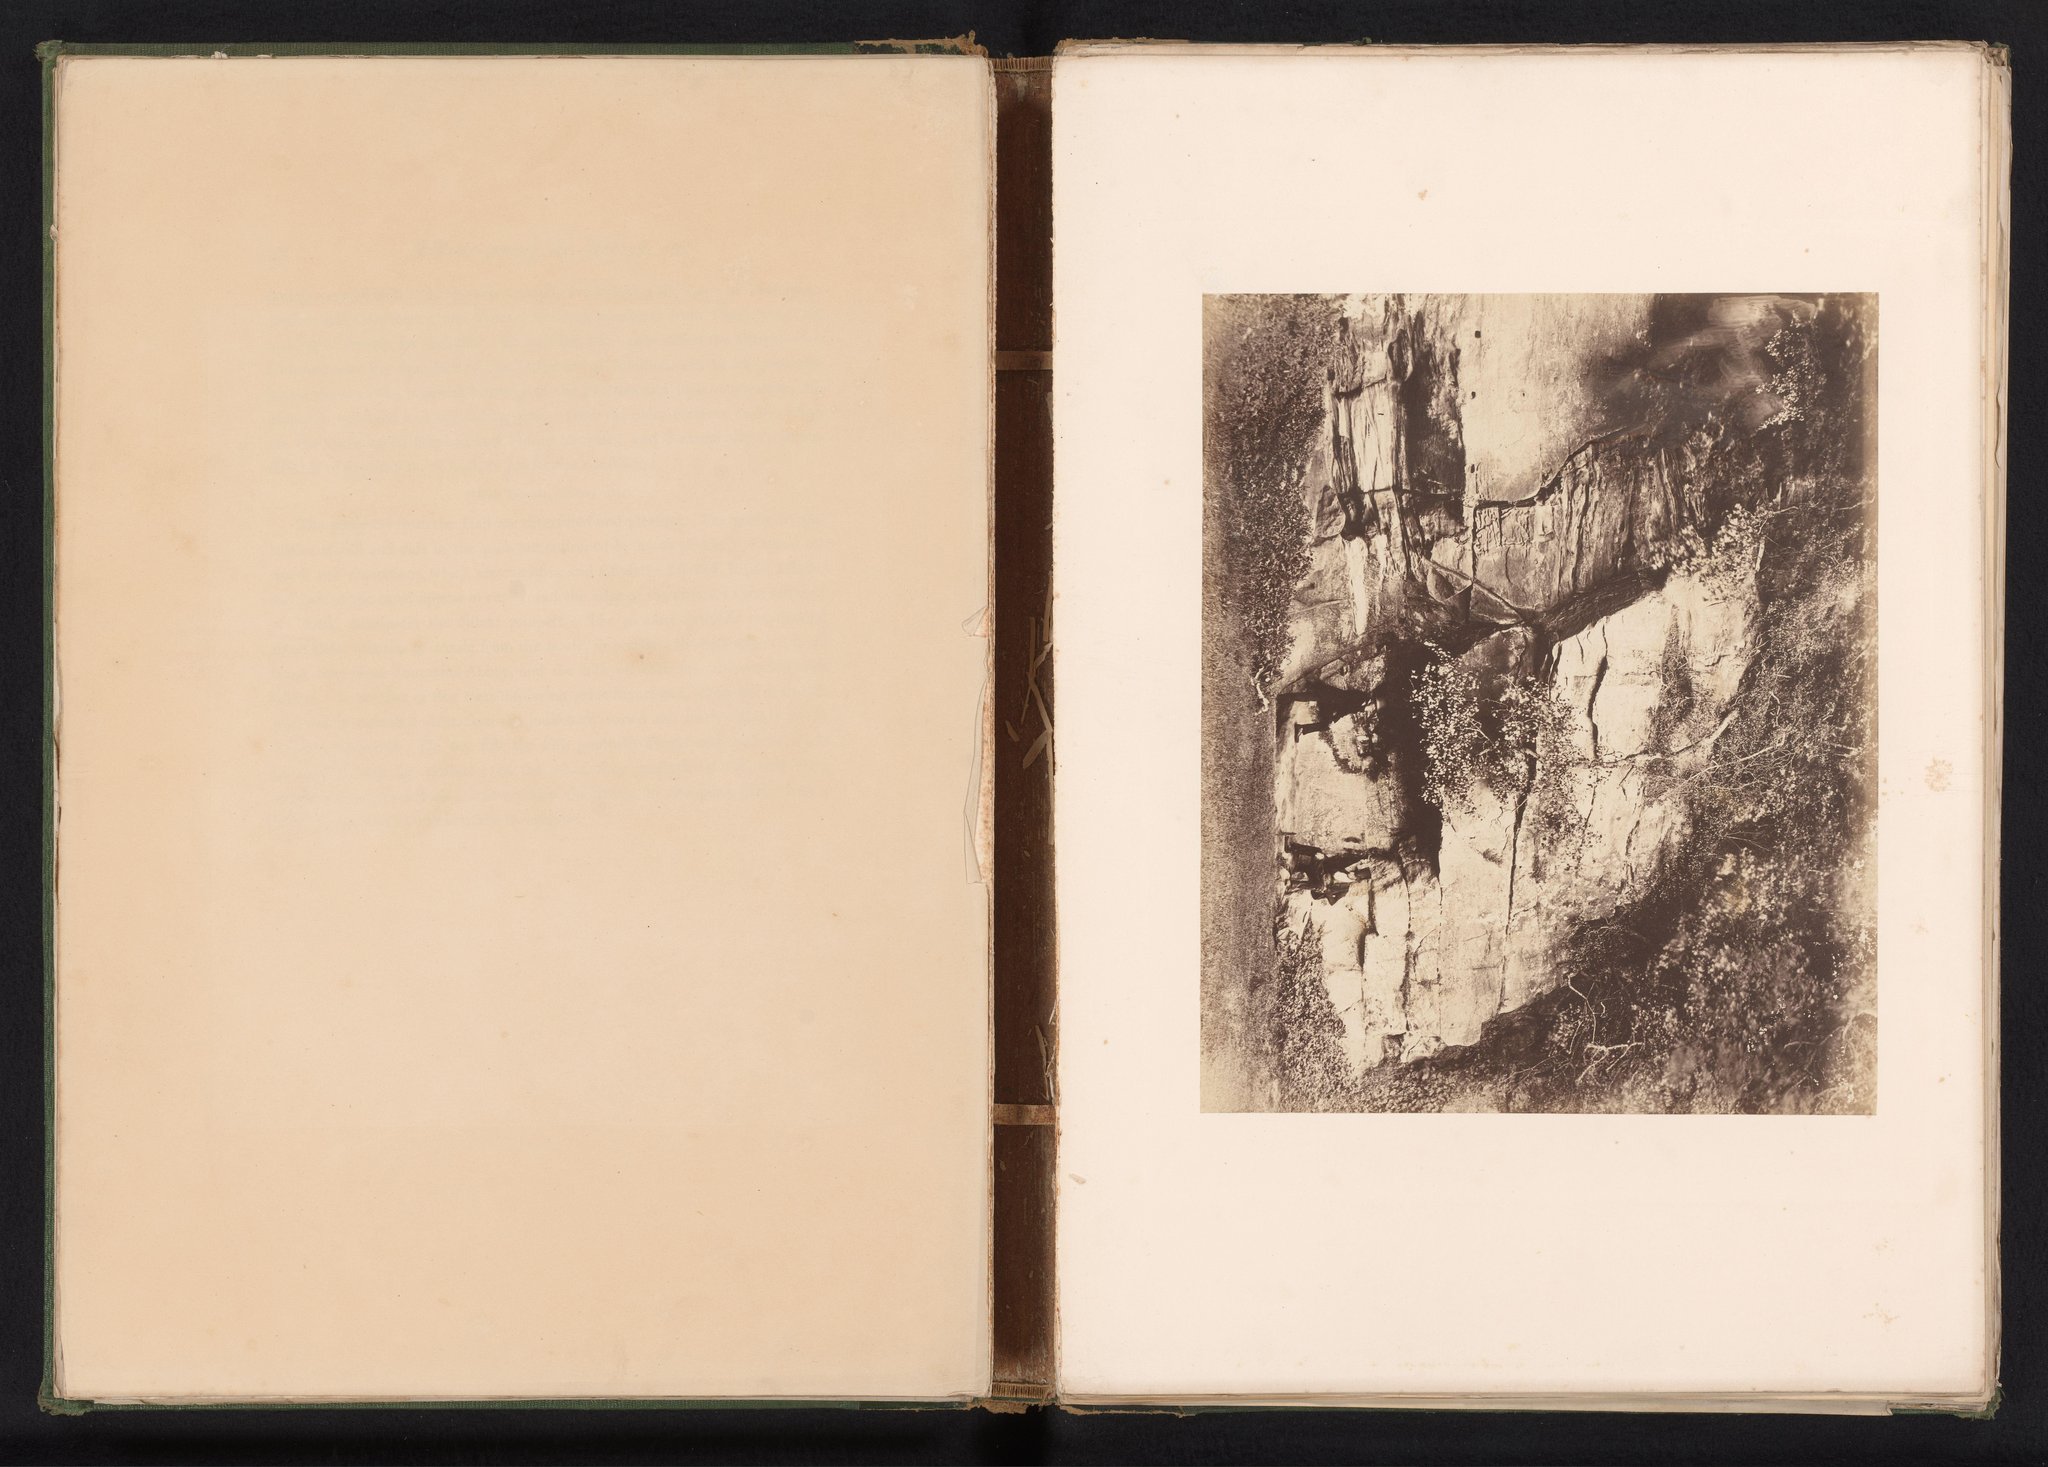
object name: page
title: Gezicht op de Echo Rock bij de Fountains Abbey nabij Ripon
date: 1851-1856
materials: photographic support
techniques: albumen print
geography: fountains abbey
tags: rock-formations (+ landscape with figures, staffage)